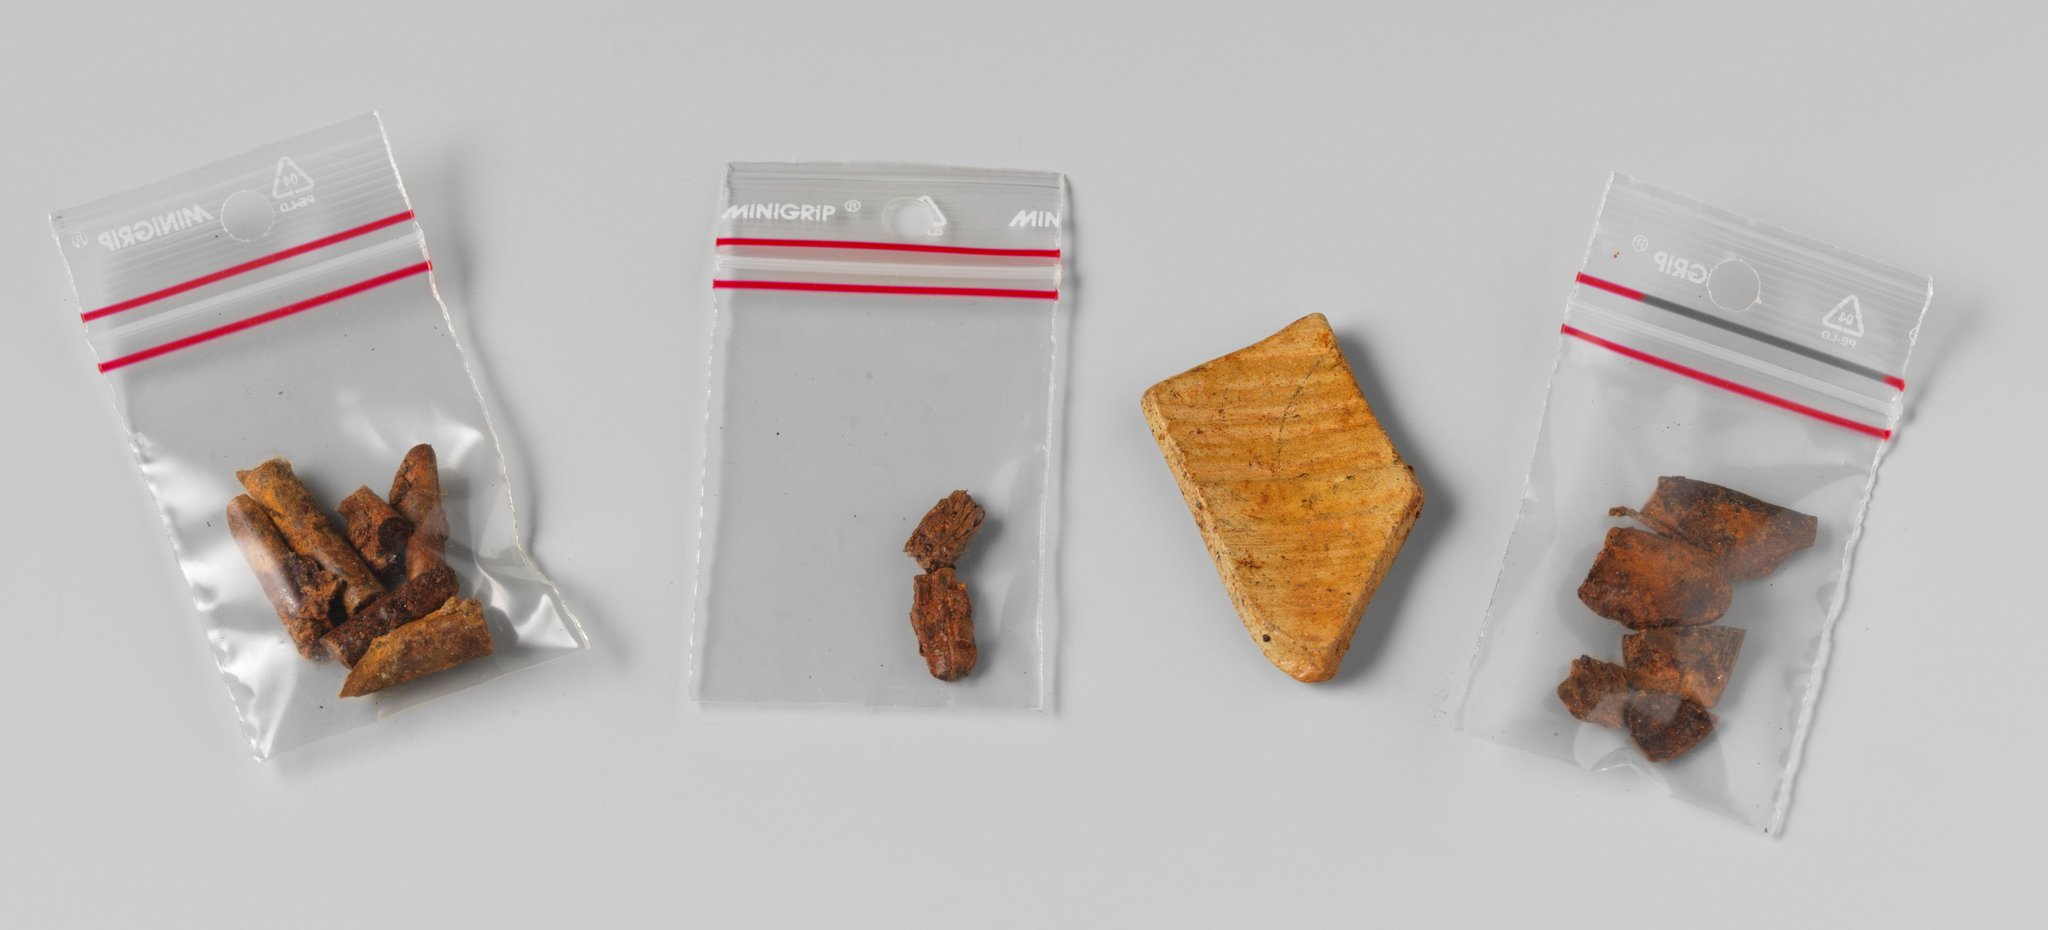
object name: pipe stem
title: Fragmenten varia uit het wrak van de Oostindiëvaarder Hollandia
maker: Anonymous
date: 1700-1743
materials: glass, clay, wood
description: Zes fragmenten pijpensteel, vijf fragmenten pijpenkop, één scherf steengoed, twee fragmenten hout, één fragment glas.